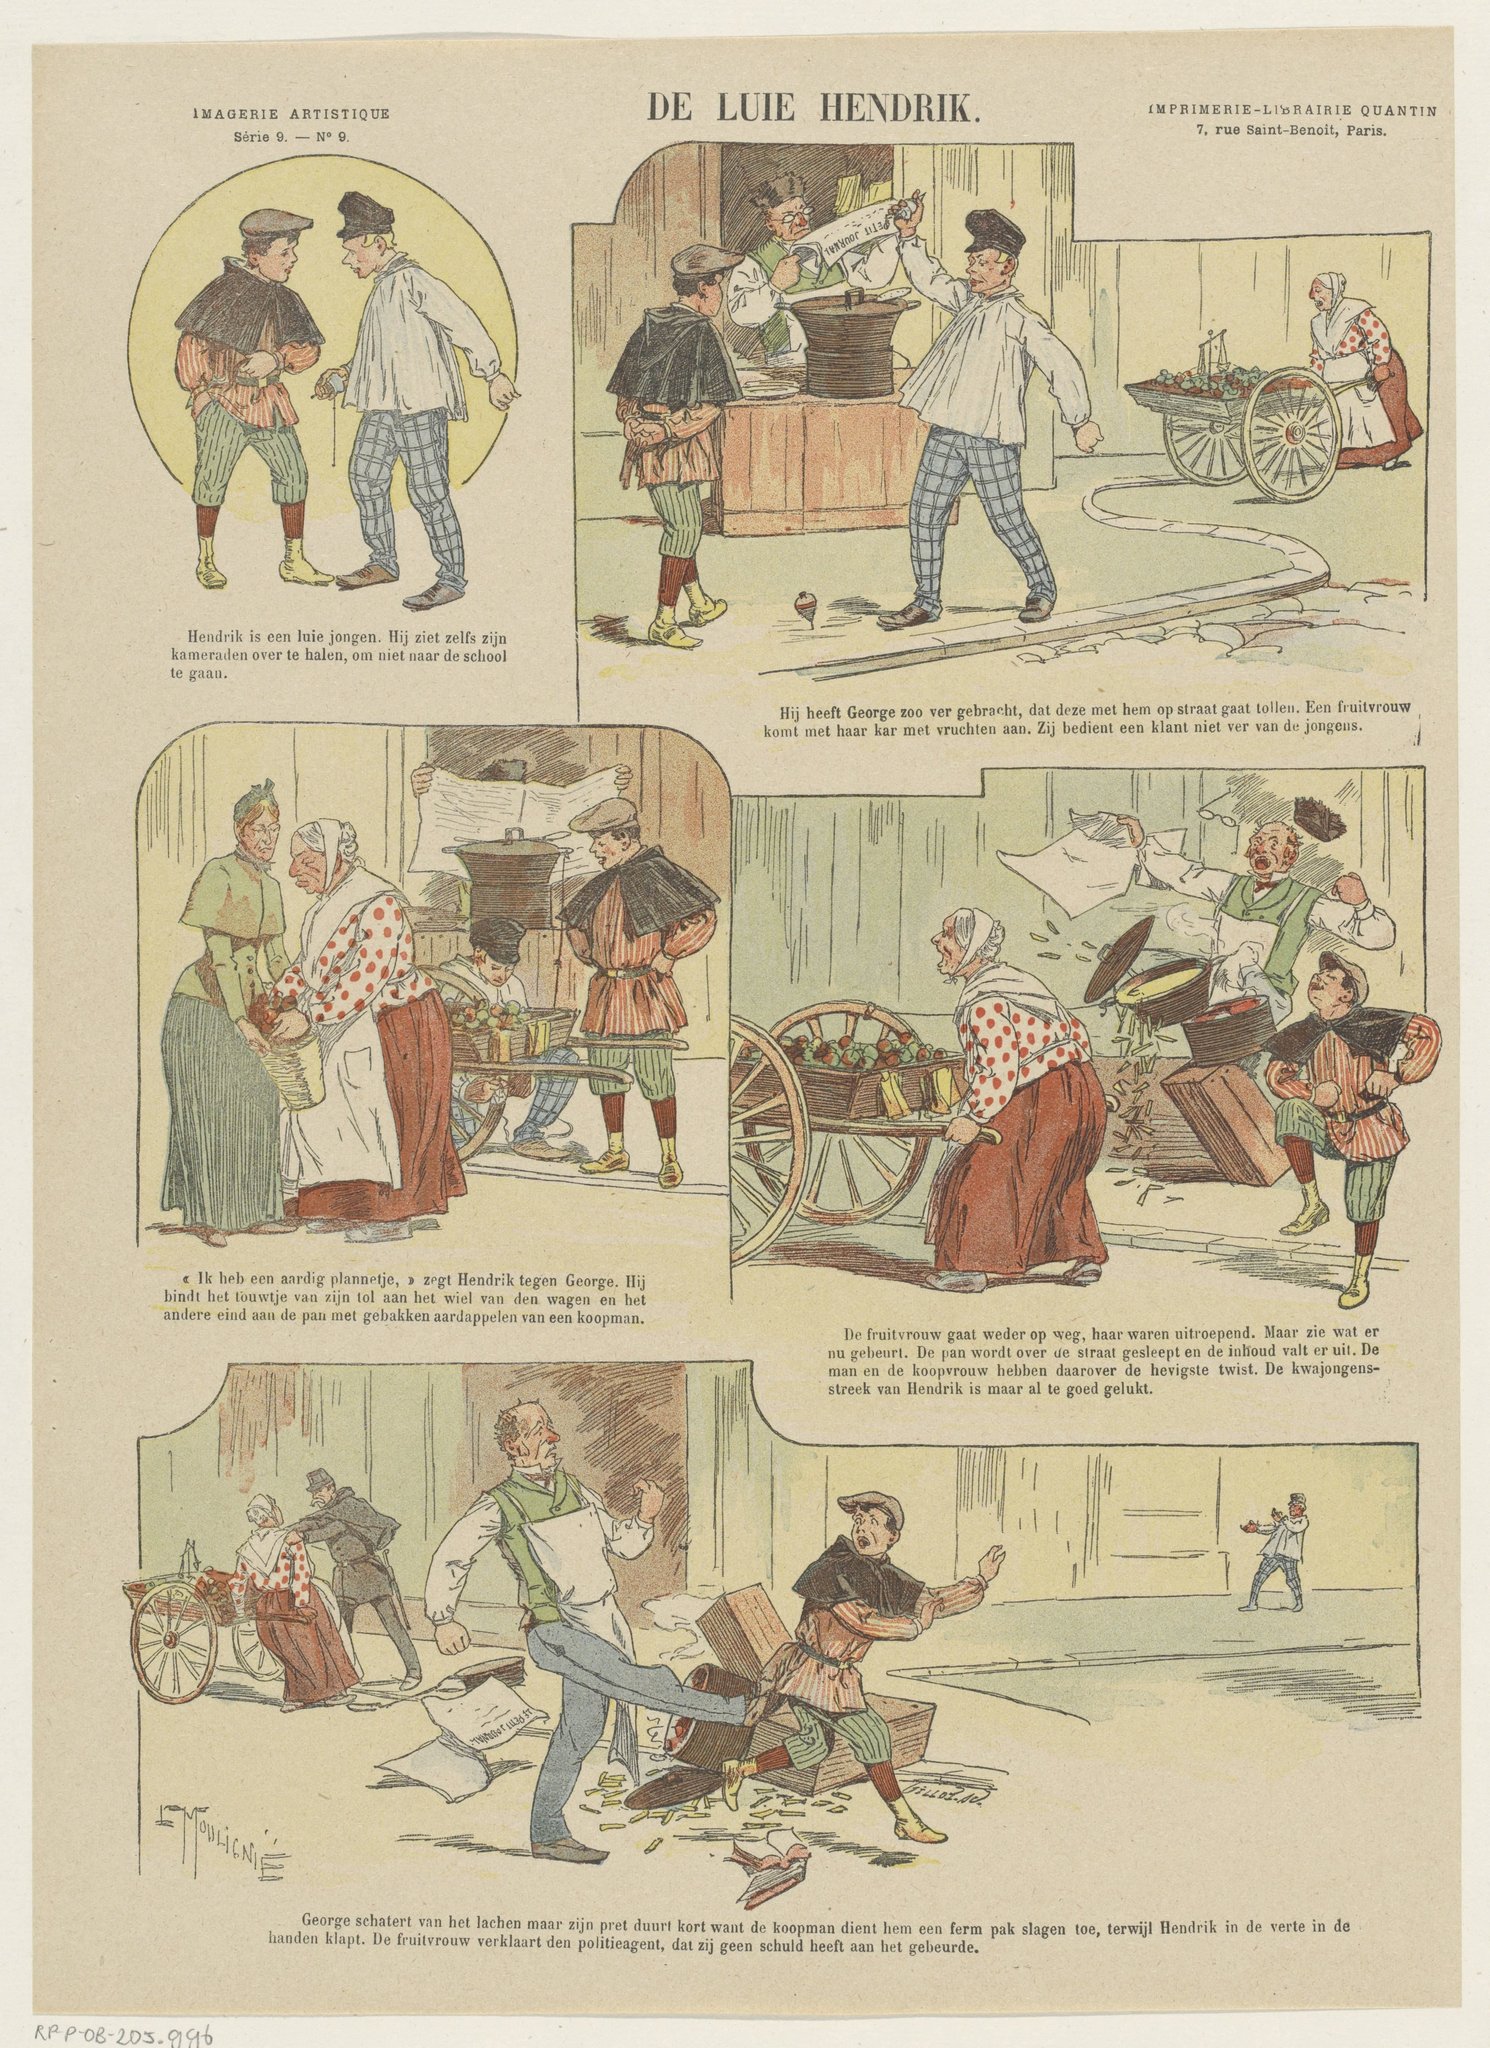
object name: print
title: De luie Hendrik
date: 1876-1890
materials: paper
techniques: lithograph, letterpress printing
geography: paris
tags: mischief-making play, bad behaviour, tales and fairy tales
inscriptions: collector's mark: Lugt 2760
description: Blad met 5 voorstellingen van twee kwajongens Hendrik en George, die een streek uithalen. Ze binden met een touw een pan aan een kar vast, waardoor de inhoud van de pan op straat komt te liggen. Onder elke afbeelding een onderschrift. Genummerd linksboven: Série 9. - No. 9.